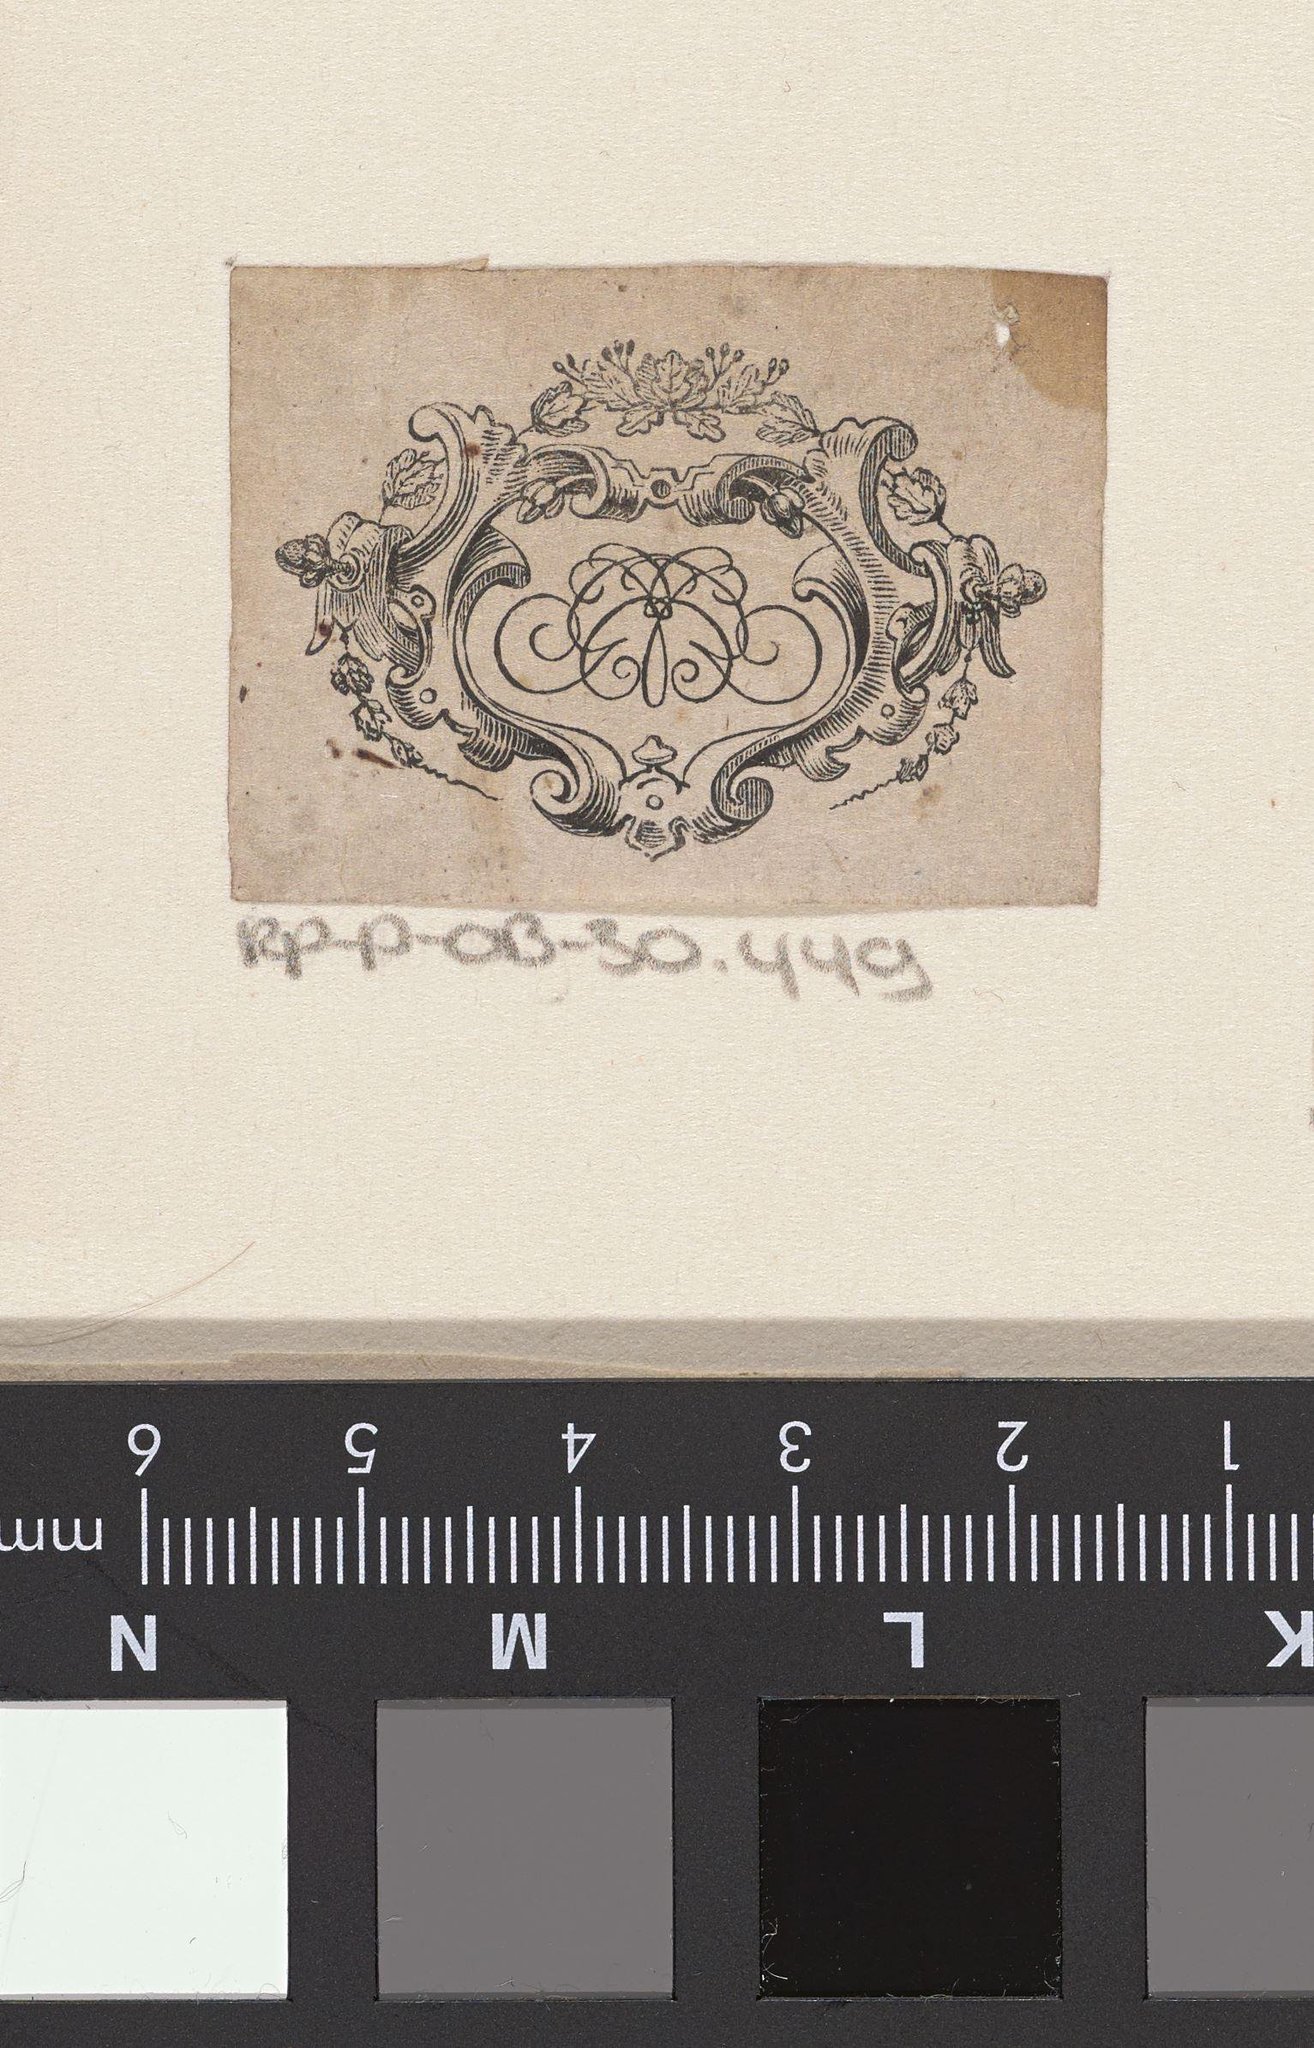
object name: print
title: Vignet met een monogram in een geornamenteerde omlijsting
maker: isaac weissenbruch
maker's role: print maker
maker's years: 1826-1912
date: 1836-1912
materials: paper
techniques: engraving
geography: netherlands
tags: vignette, letter combinations such as letterword, anagram, letter square, monogram, etc.